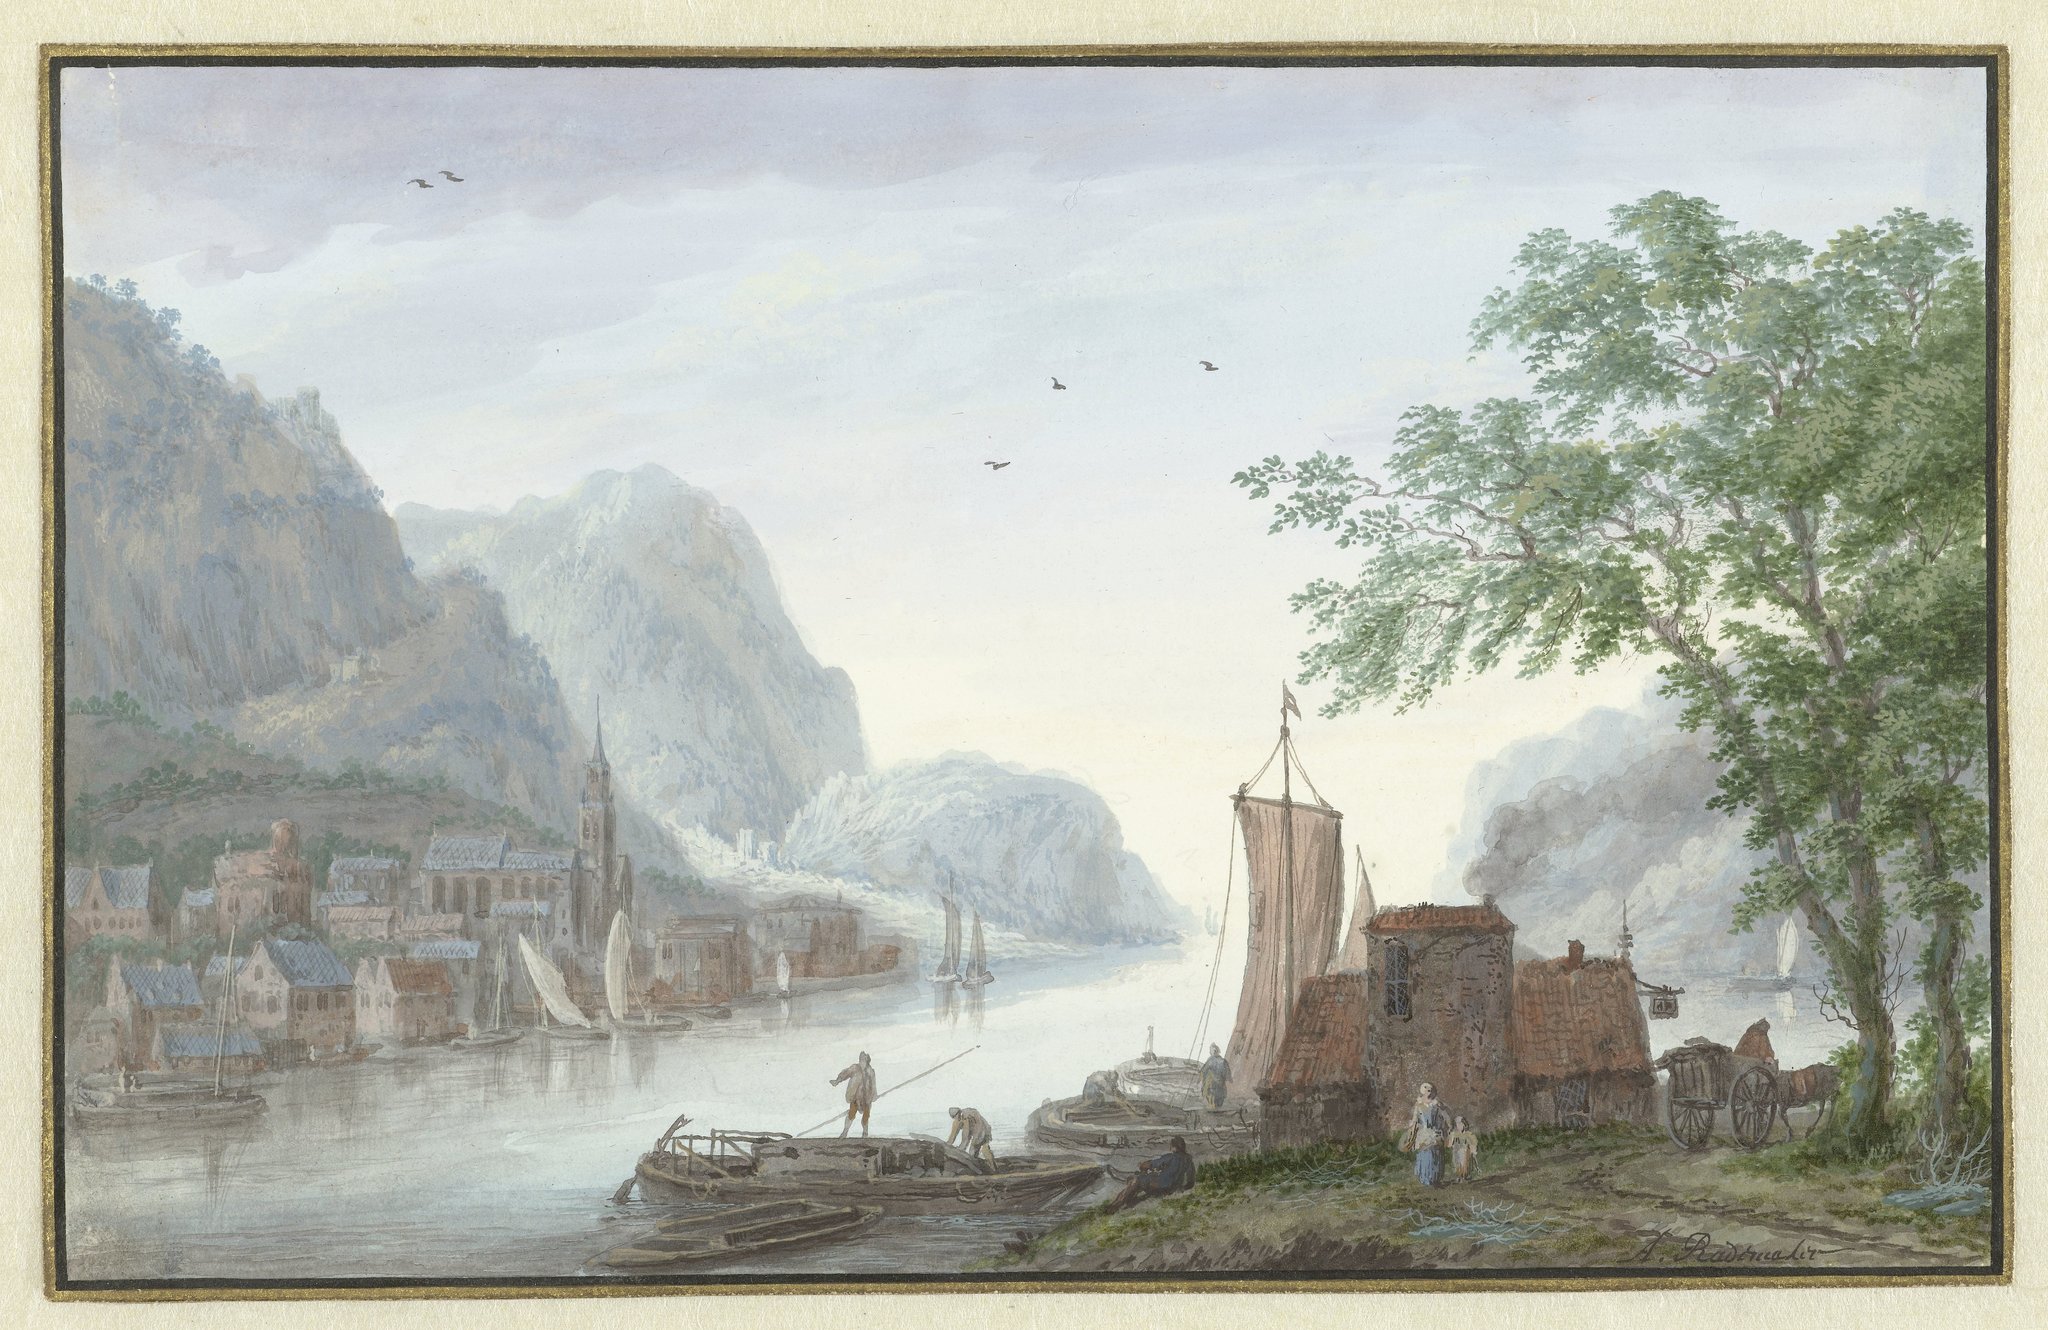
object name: drawing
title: Bergachtig landschap met gezicht op een dorp aan een rivier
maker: abraham rademaker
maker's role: draughtsman, print maker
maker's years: 1676-1735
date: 1685-1735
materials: paint, gouache, ink, paper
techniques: pen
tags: prospect of village, silhouette of village, landscapes with waters, waterscapes, seascapes (in the temperate zone), mountains